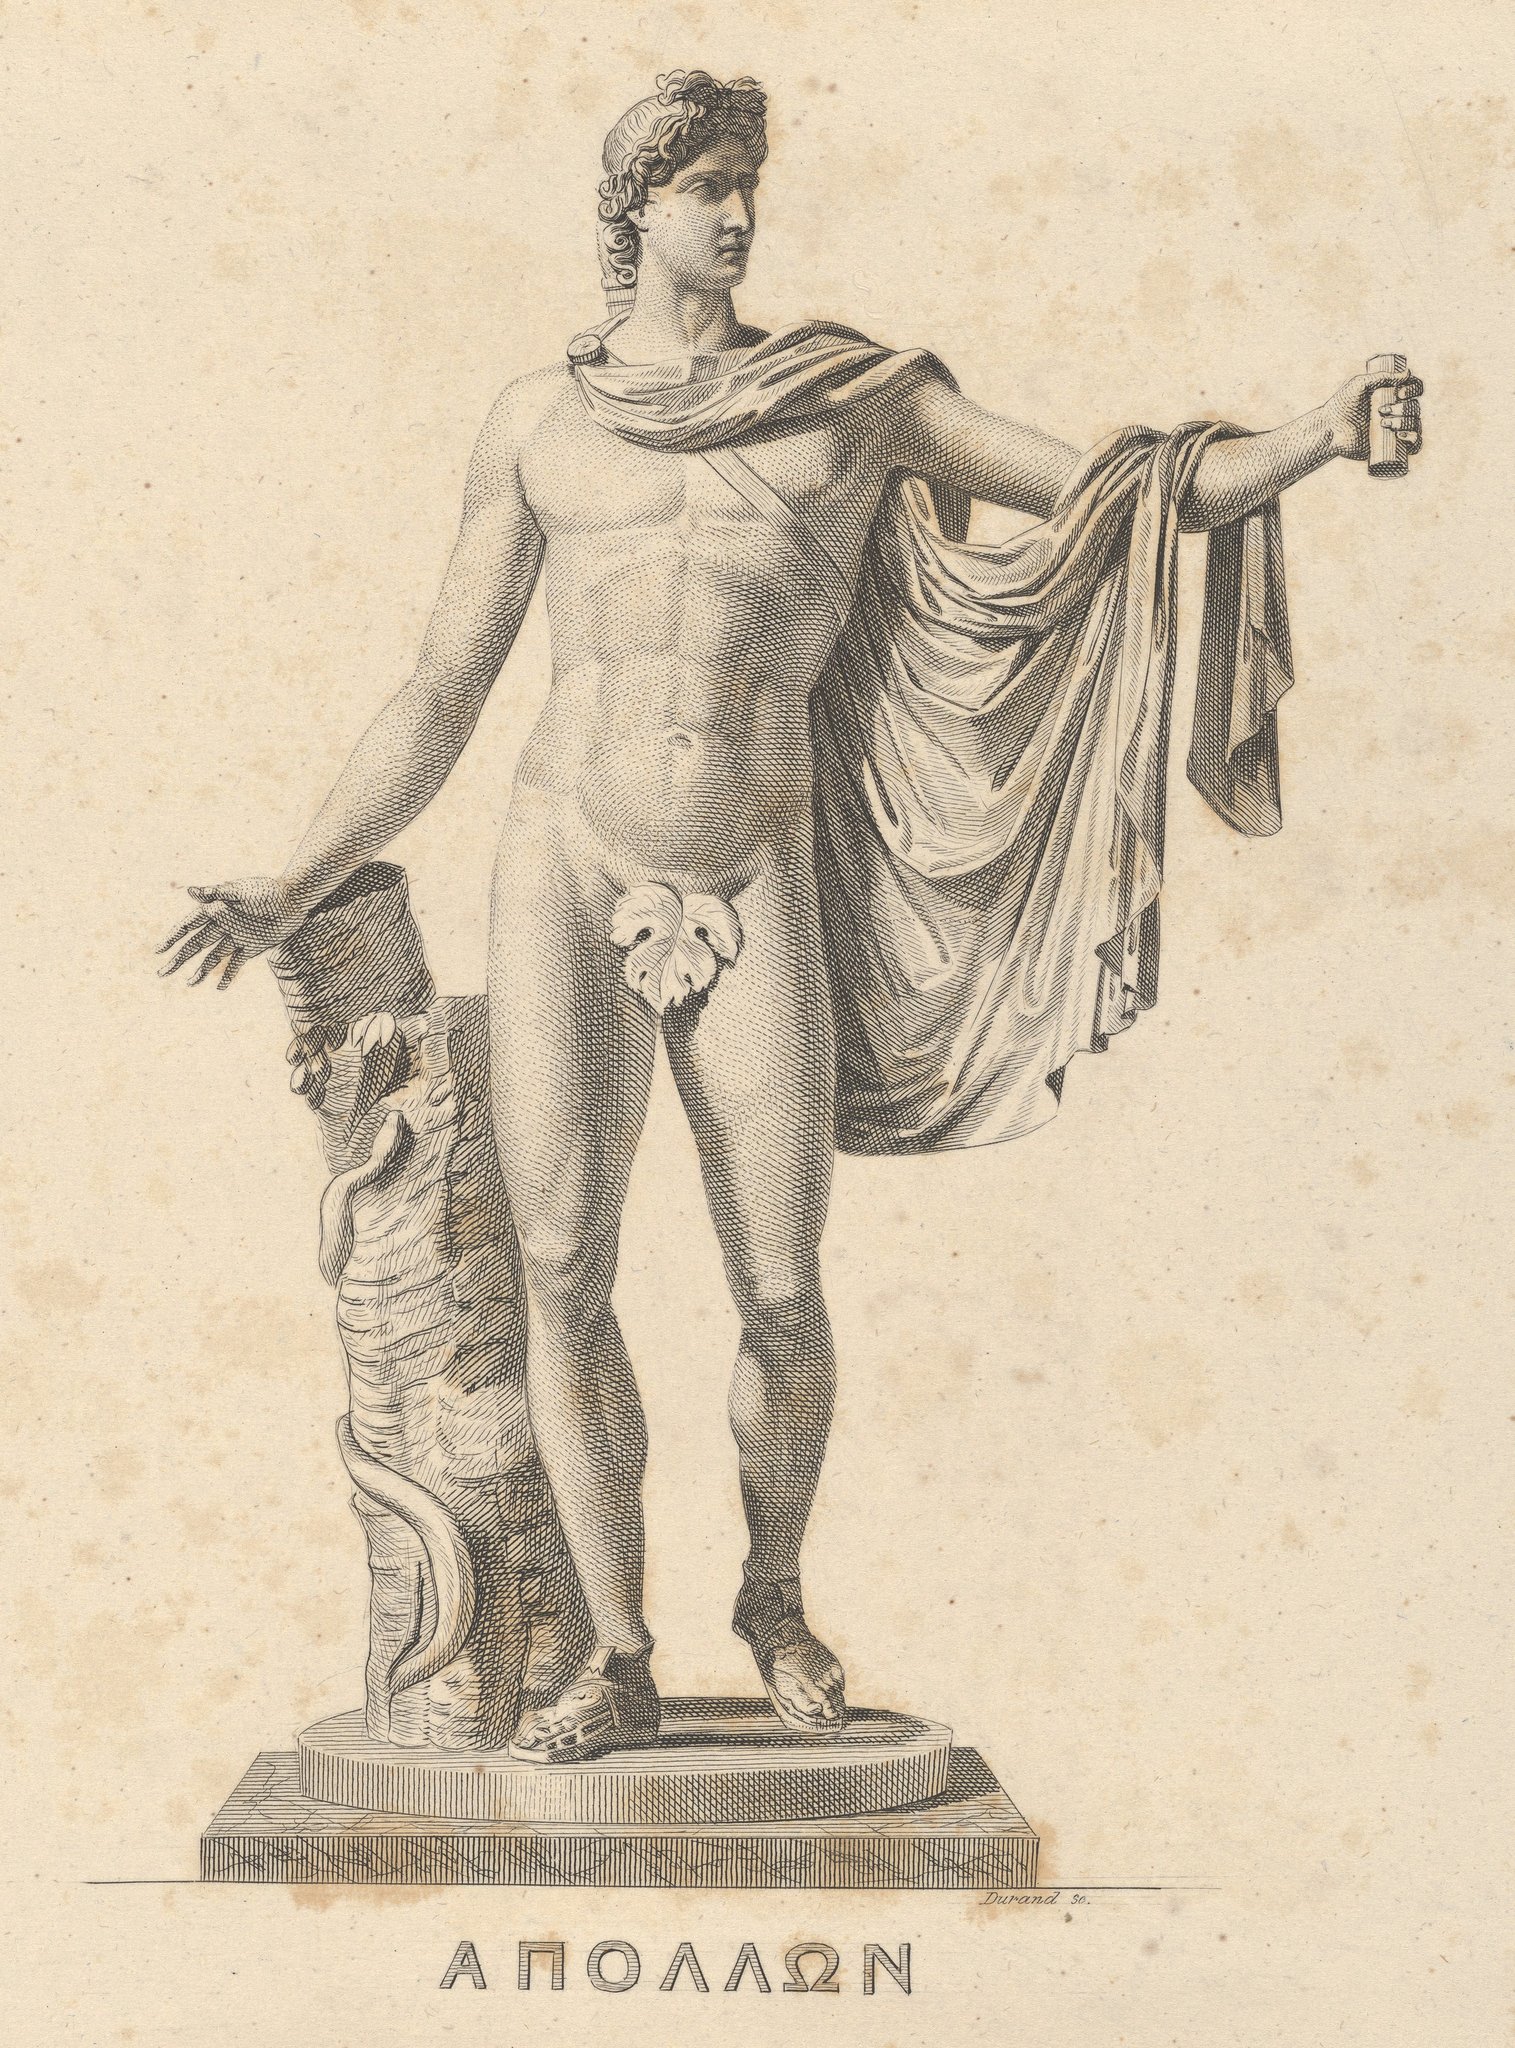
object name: print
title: Apollo Belvedere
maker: asher brown durand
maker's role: artist and engraver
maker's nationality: american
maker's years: 1796-1886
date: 1825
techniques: engraving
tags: sculpture,apollo